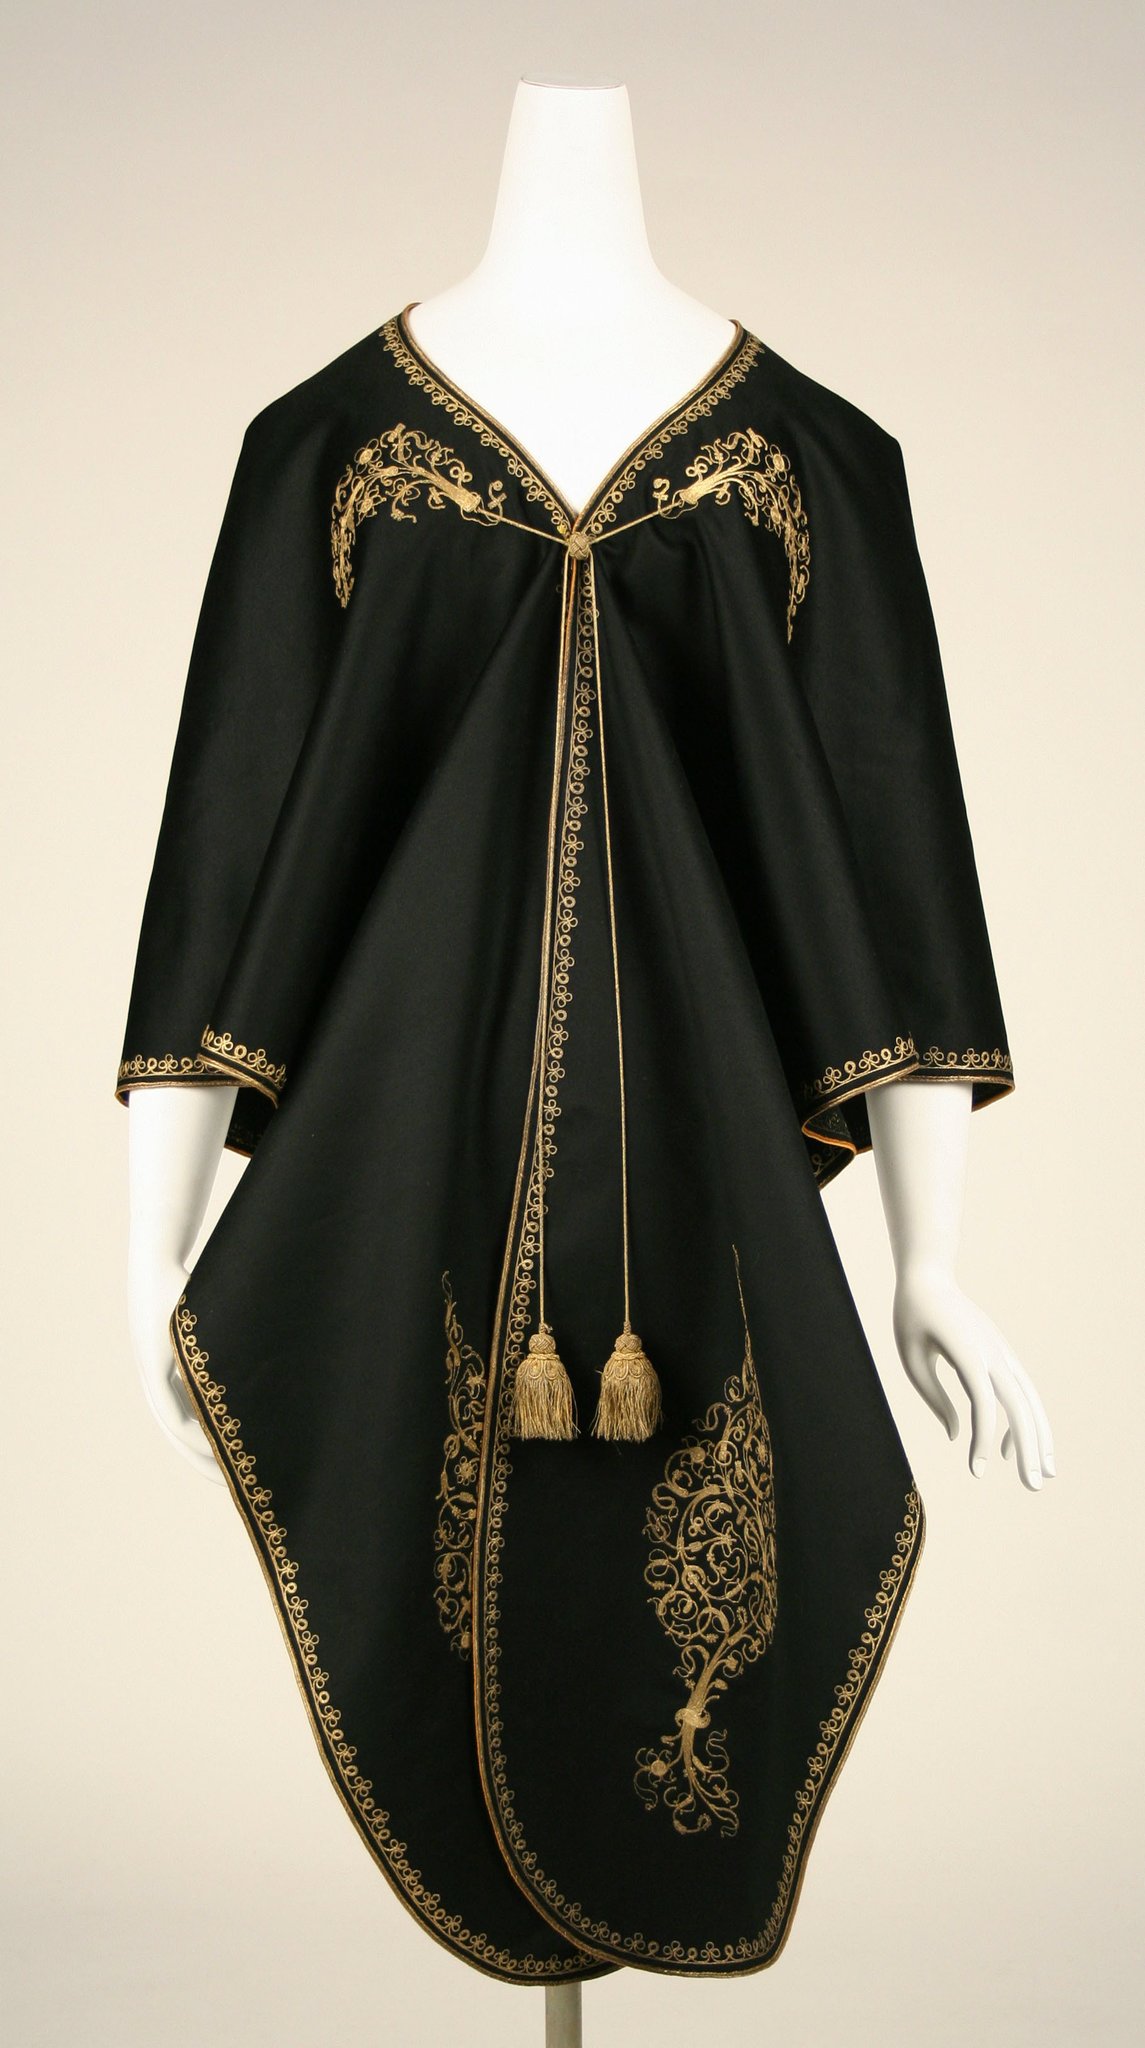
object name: bashlik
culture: asian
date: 1860-1869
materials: wool